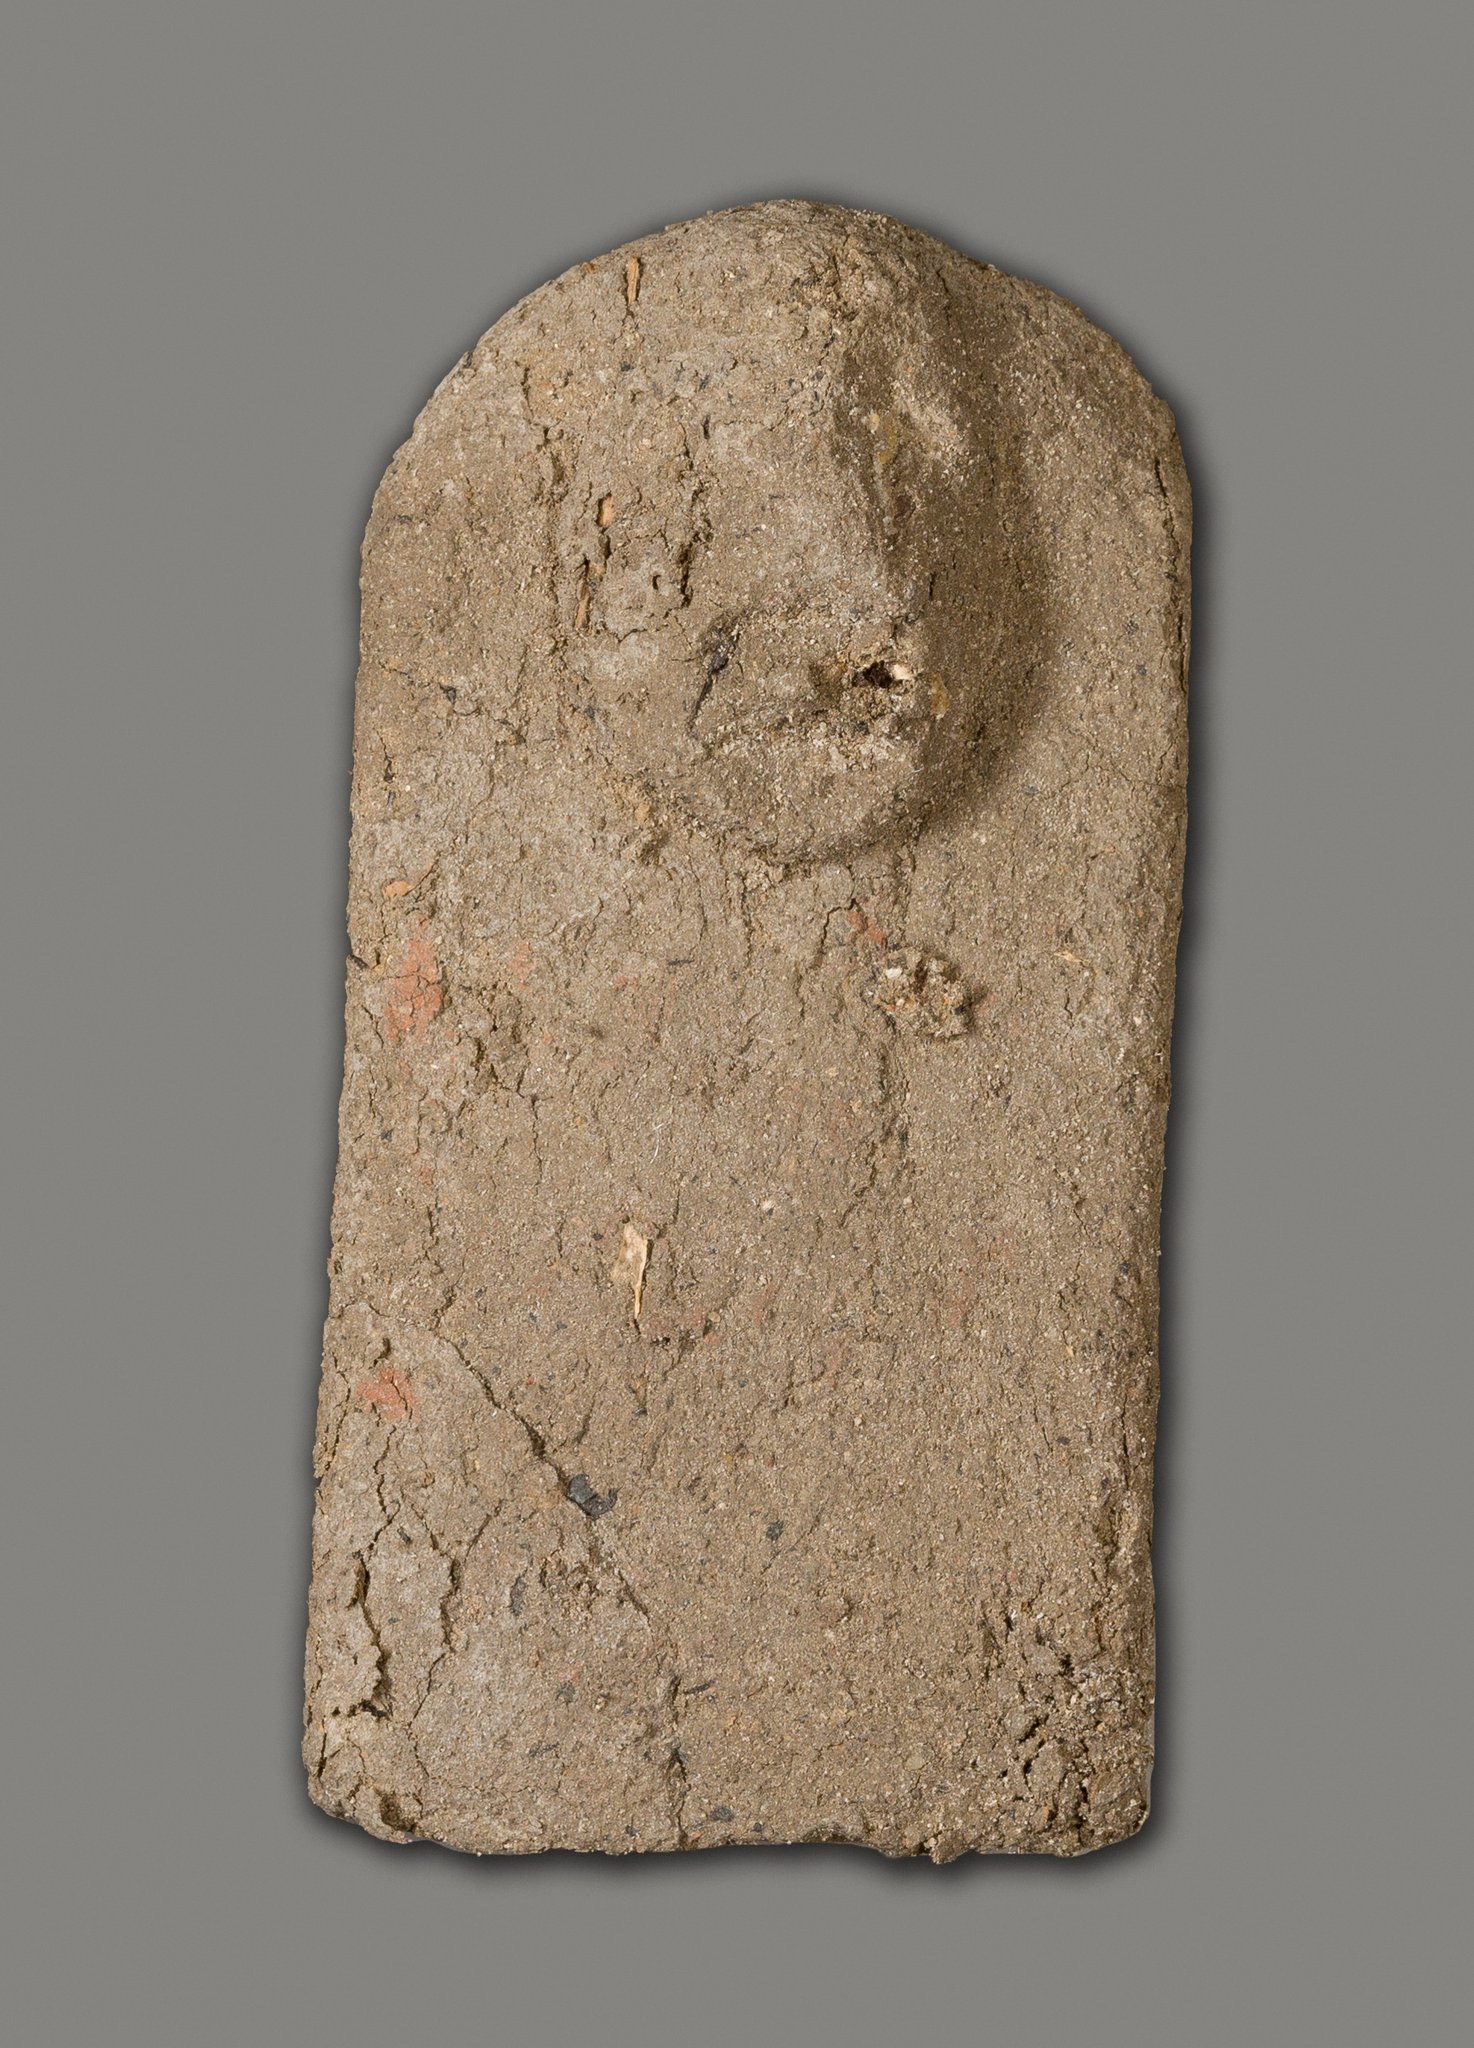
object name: figure, magical, execration, tablet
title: Magical Figure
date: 1802-1550 BCE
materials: clay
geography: egypt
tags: faces